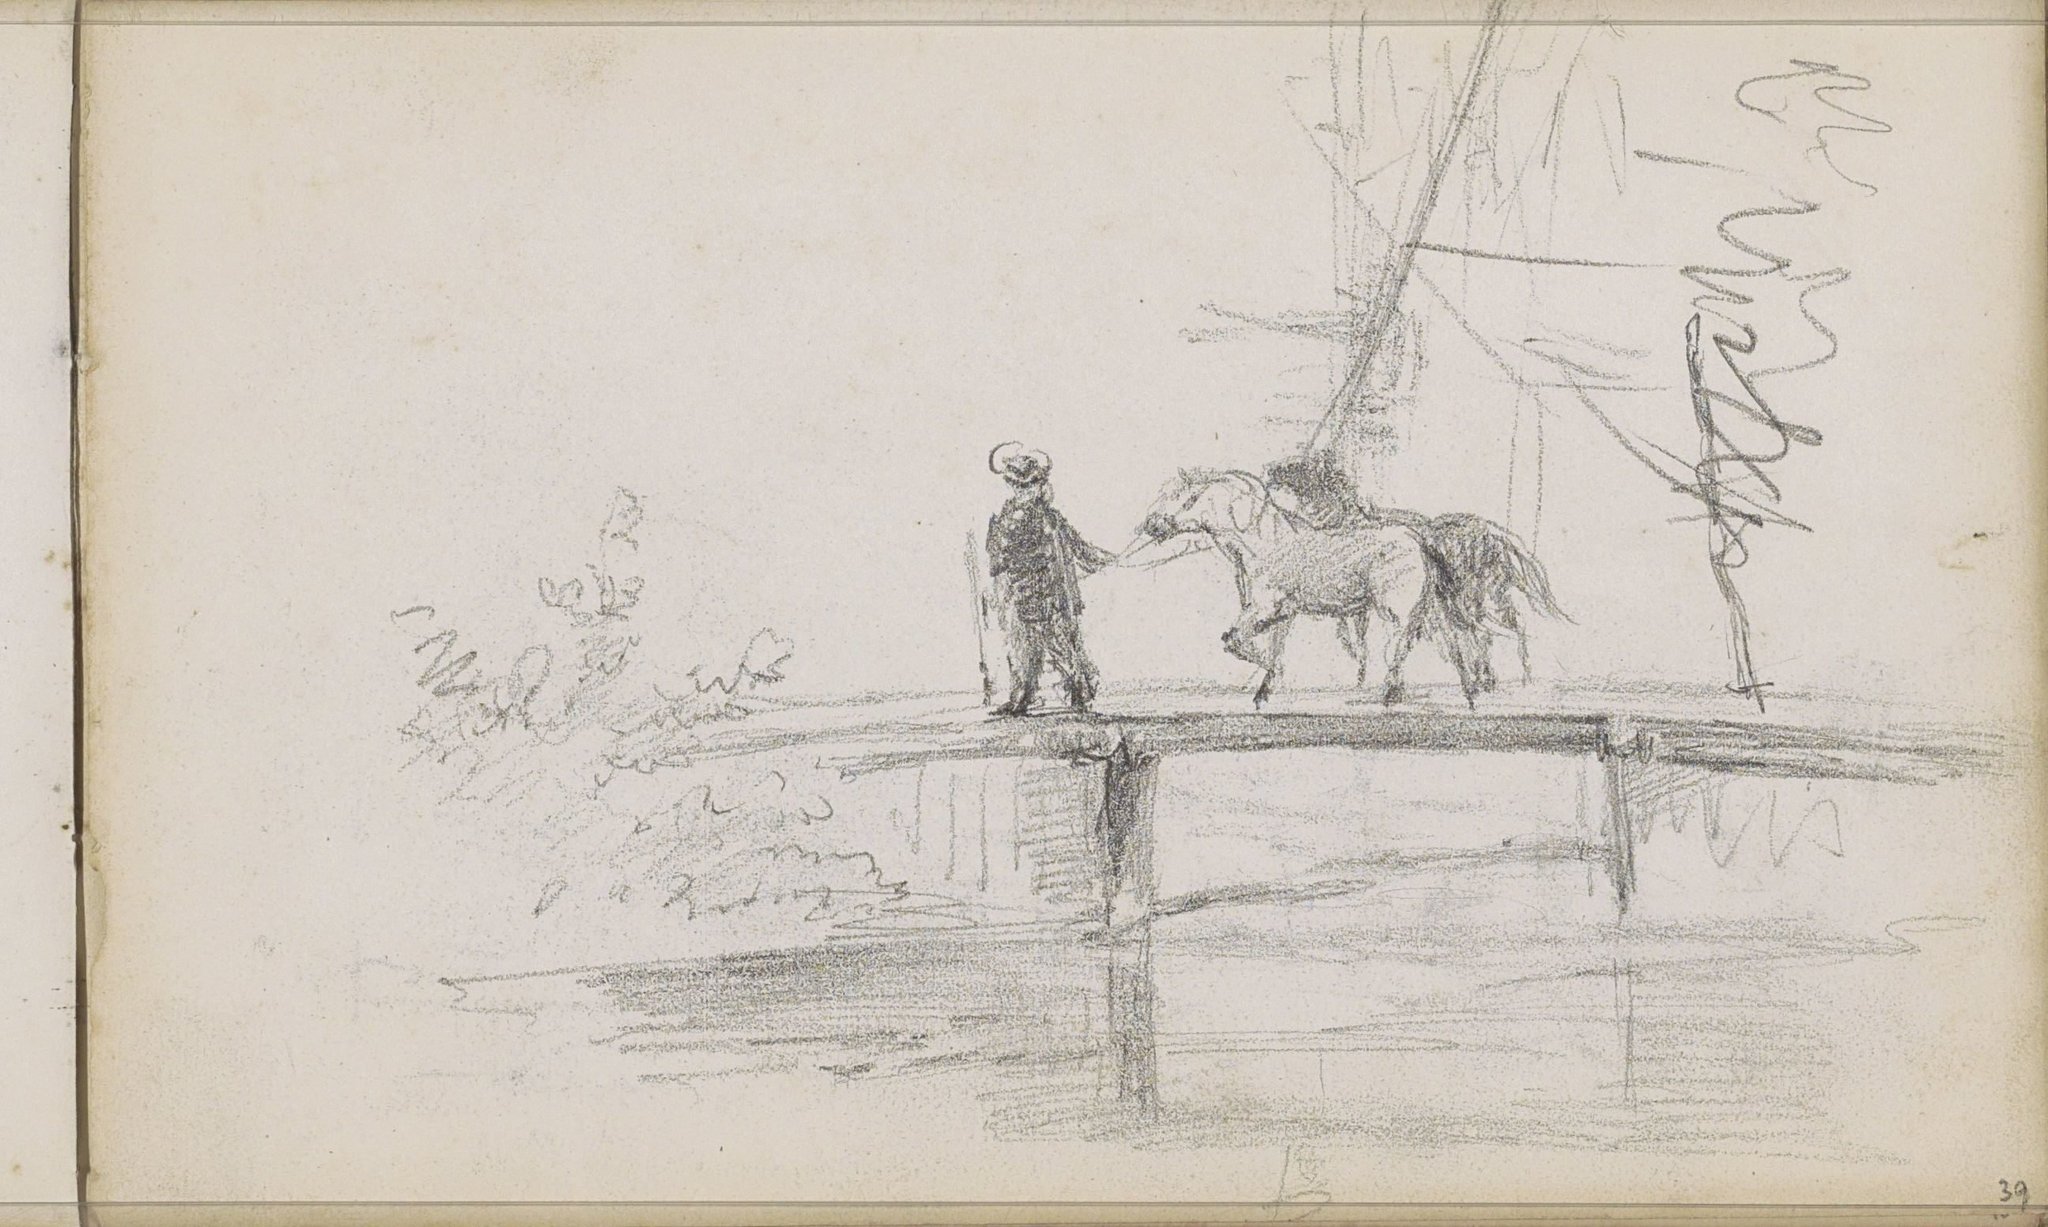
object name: sketchbook leaf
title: Man met twee paarden op een brug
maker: willem cornelis rip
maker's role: draughtsman, painter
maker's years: 1856-1922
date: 1874-1875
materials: paper, pencil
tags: horse, bridge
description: Blad 39 recto uit een schetsboek met 46 bladen.